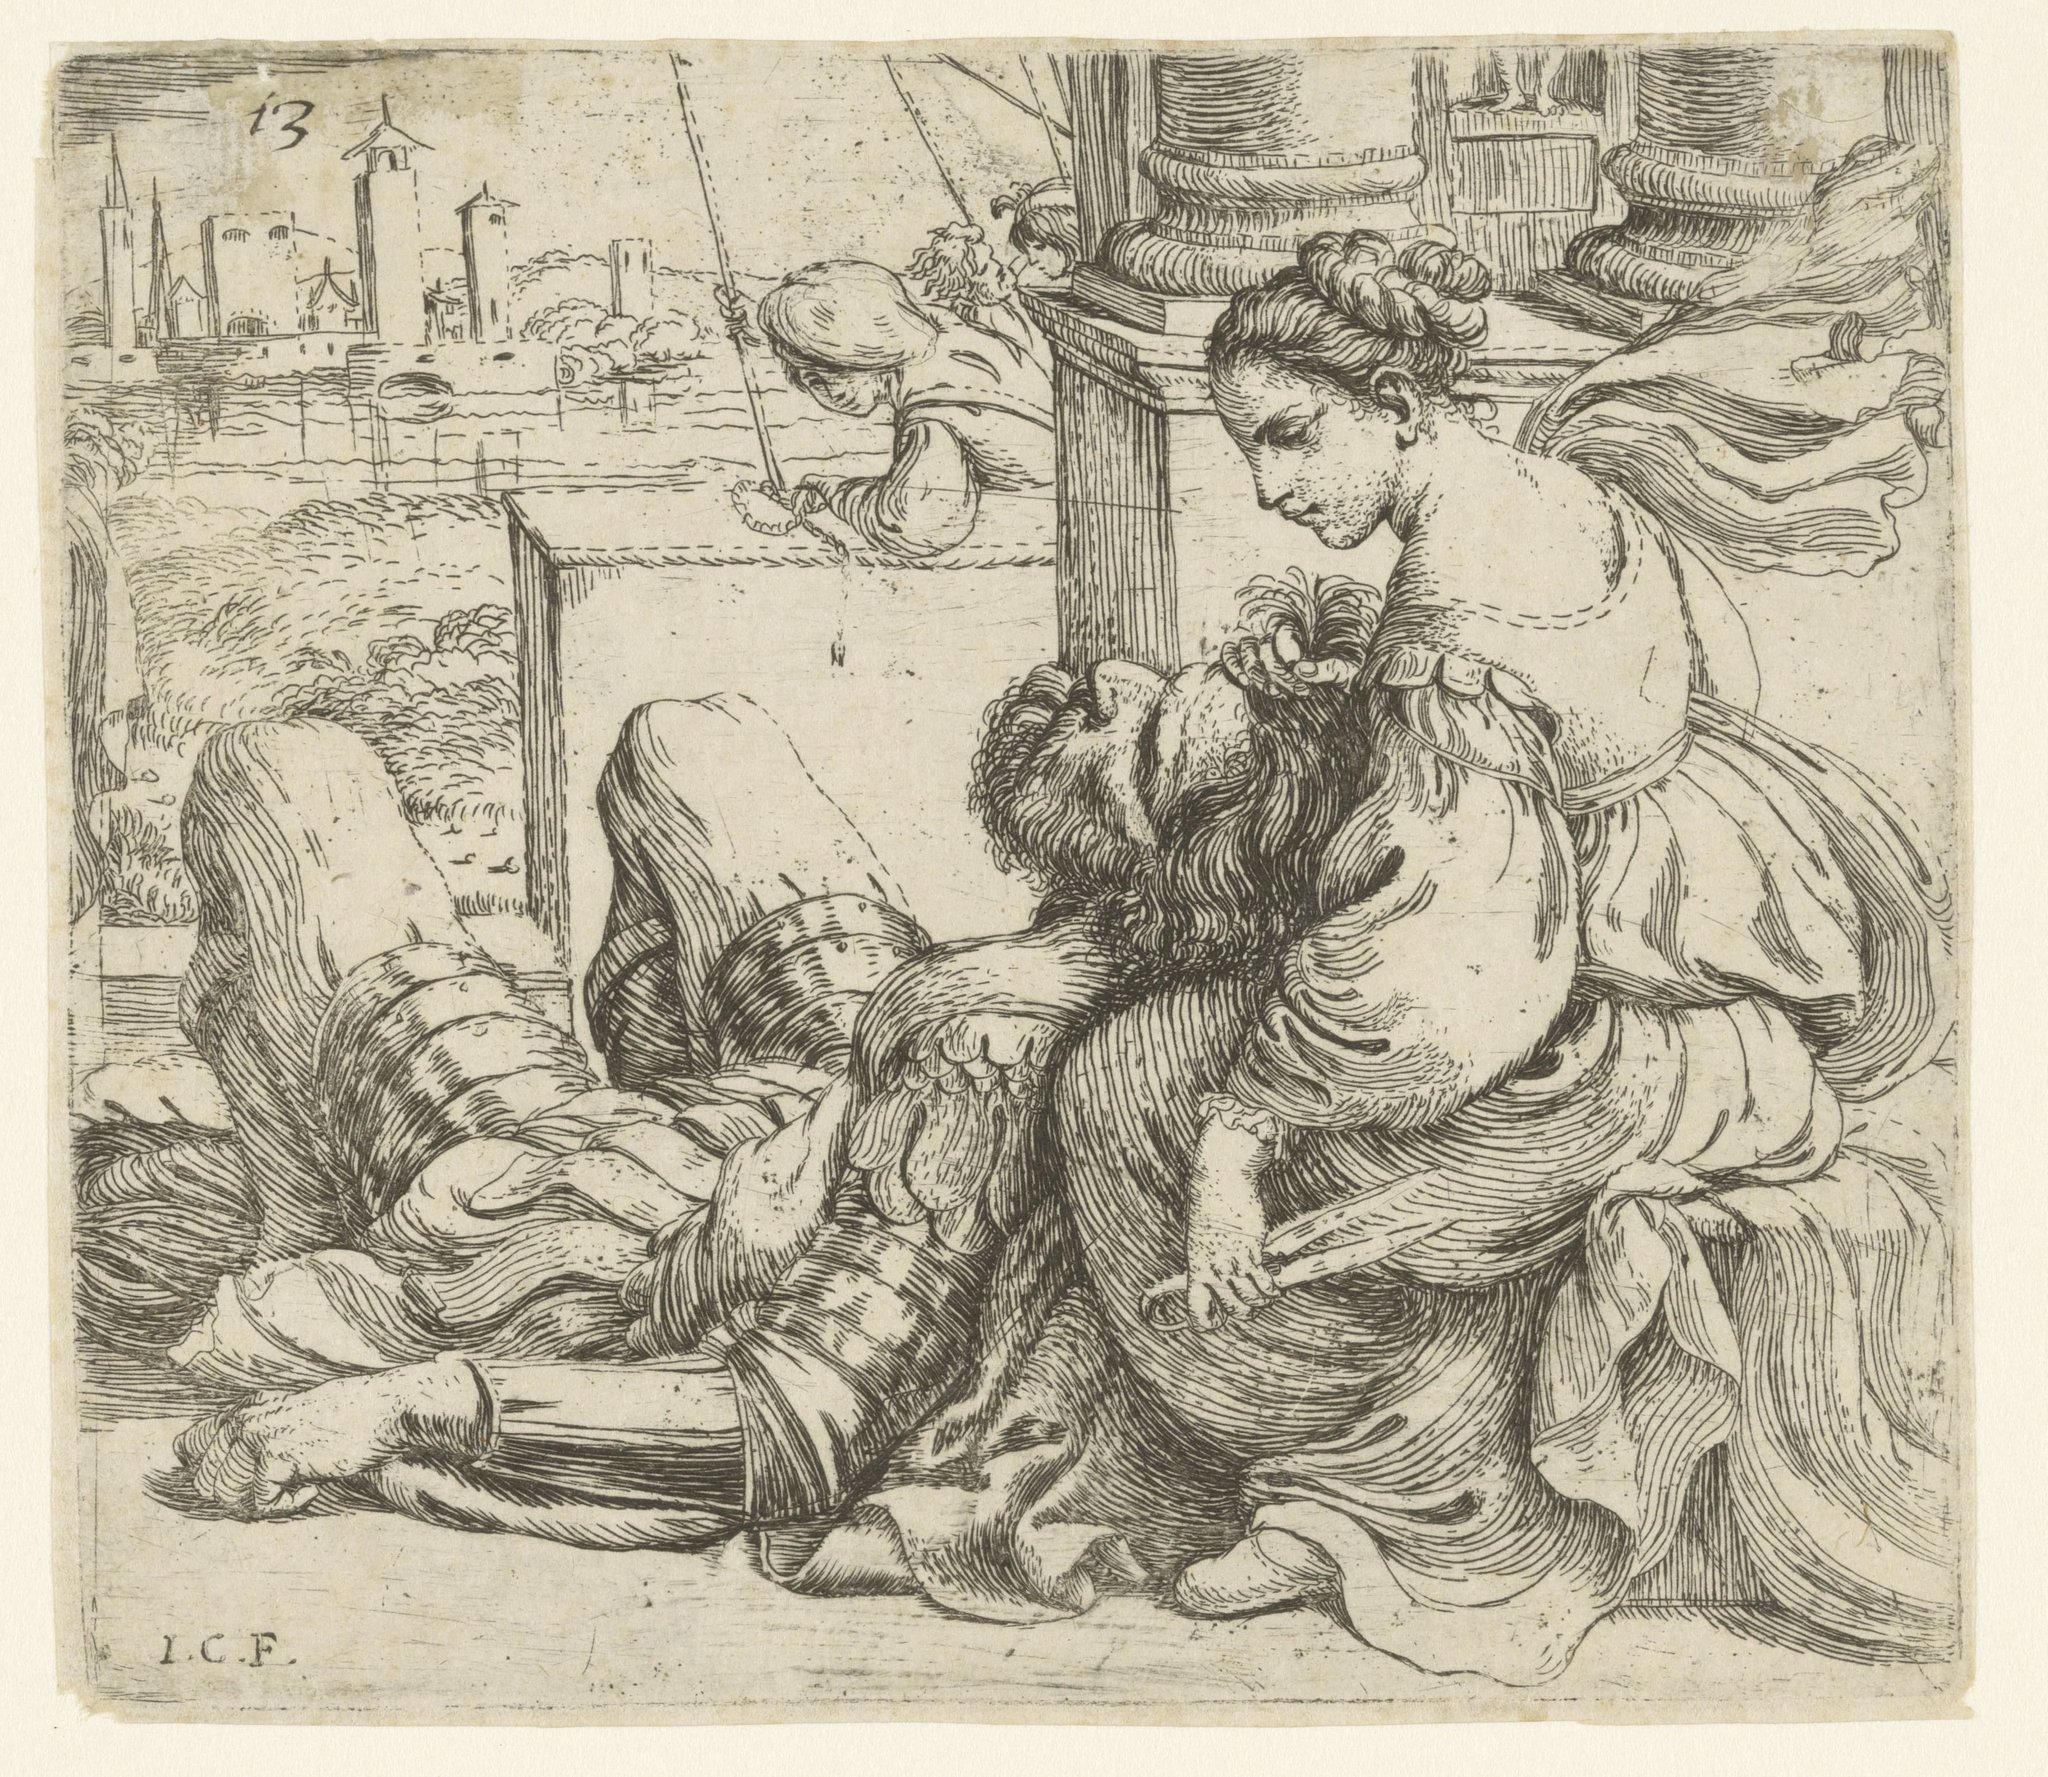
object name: print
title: Simson en Delila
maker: giuseppe caletti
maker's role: print maker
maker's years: 1595-1665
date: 1605-1665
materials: paper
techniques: etching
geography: italy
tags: samson's hairlocks are cut off by delilah, story of samson and delilah (judges 16:4-21)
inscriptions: collector's mark: Lugt 2228, collector's mark: Lugt 2760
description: Simson slaapt met zijn hoofd op de schoot van Delila. Delila staat op het punt om de haren van Simson af te knippen met een schaar. Genummerd linksboven: 13.